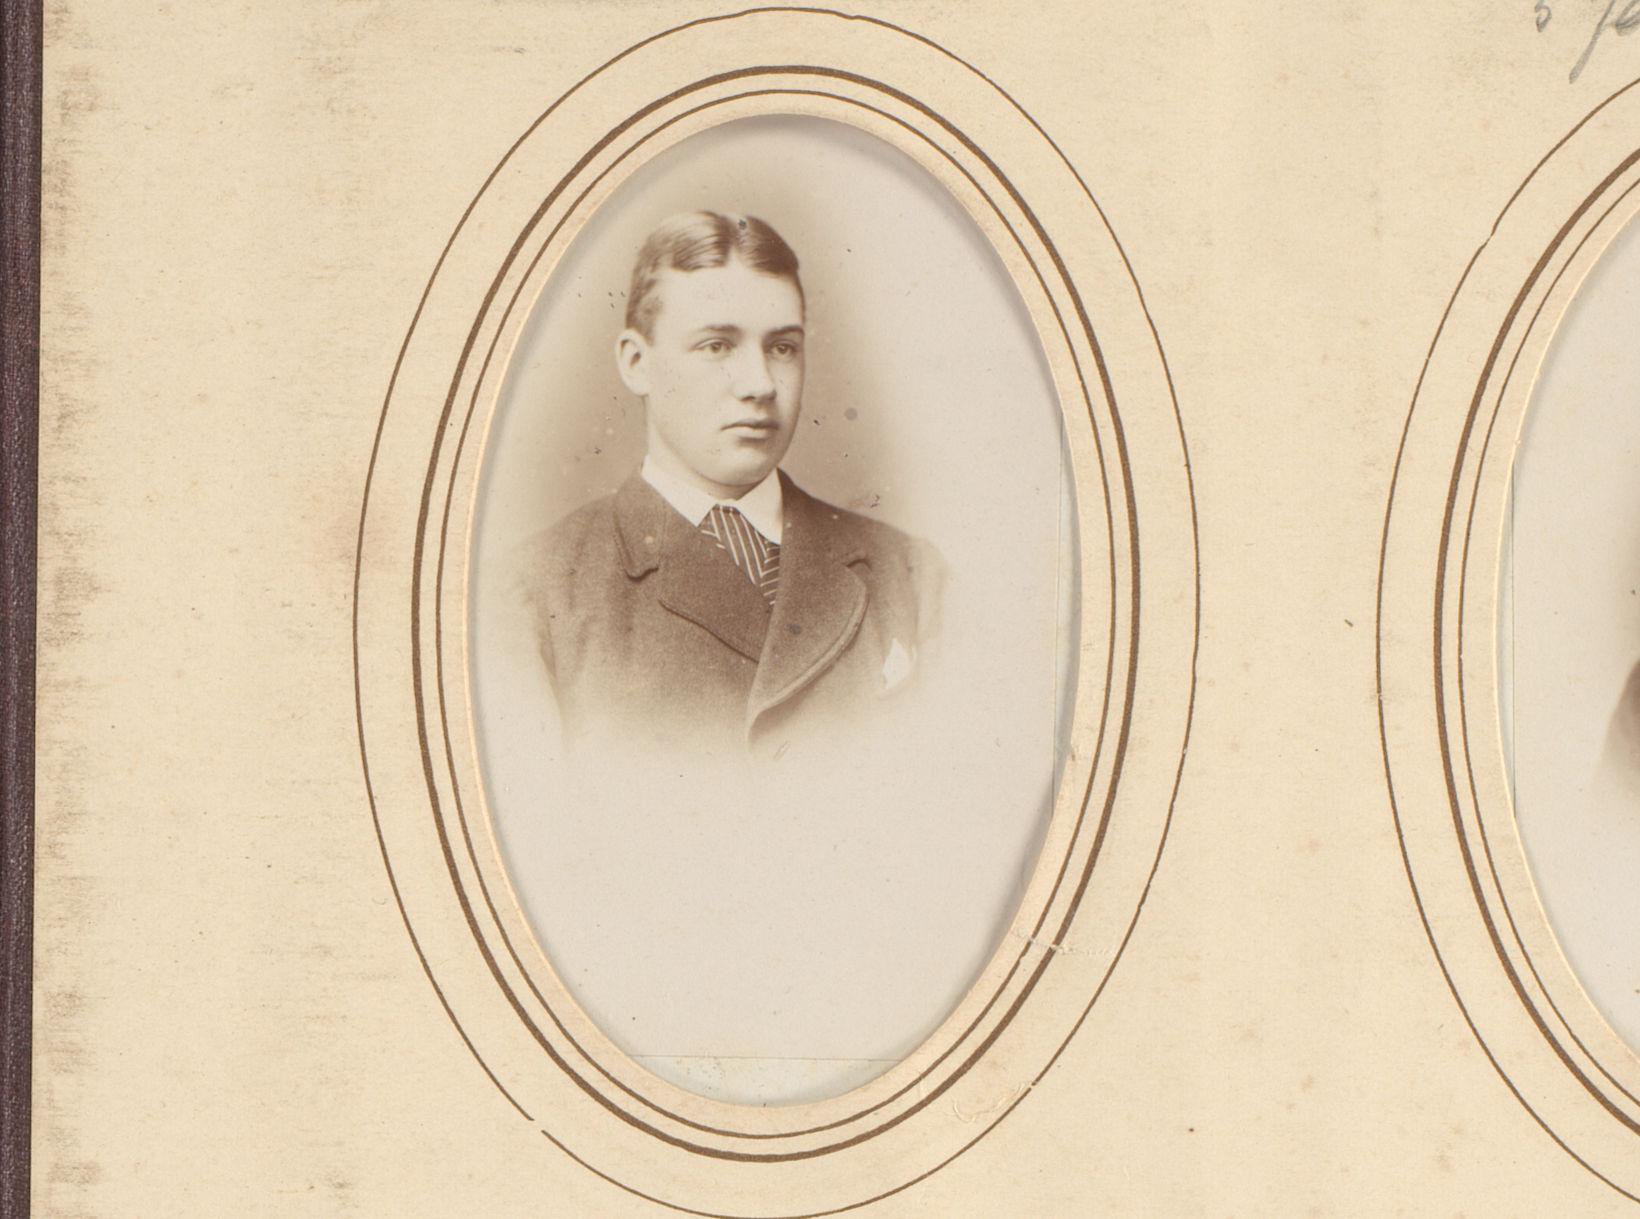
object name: carte de visite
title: Portret van een man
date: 1870-1895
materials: cardboard, photographic support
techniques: albumen print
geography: netherlands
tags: adult man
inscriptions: inscription: ‘Wegner & Mottu./ Amsterdam-Utrecht.’, inscription: ‘Photogr. Atelier/ van/ Wegner & Mottu/ Kalverstraat D 26/ Amsterdam./ Leidschestraatweg buiten Cathrijnen/ Utrecht.’